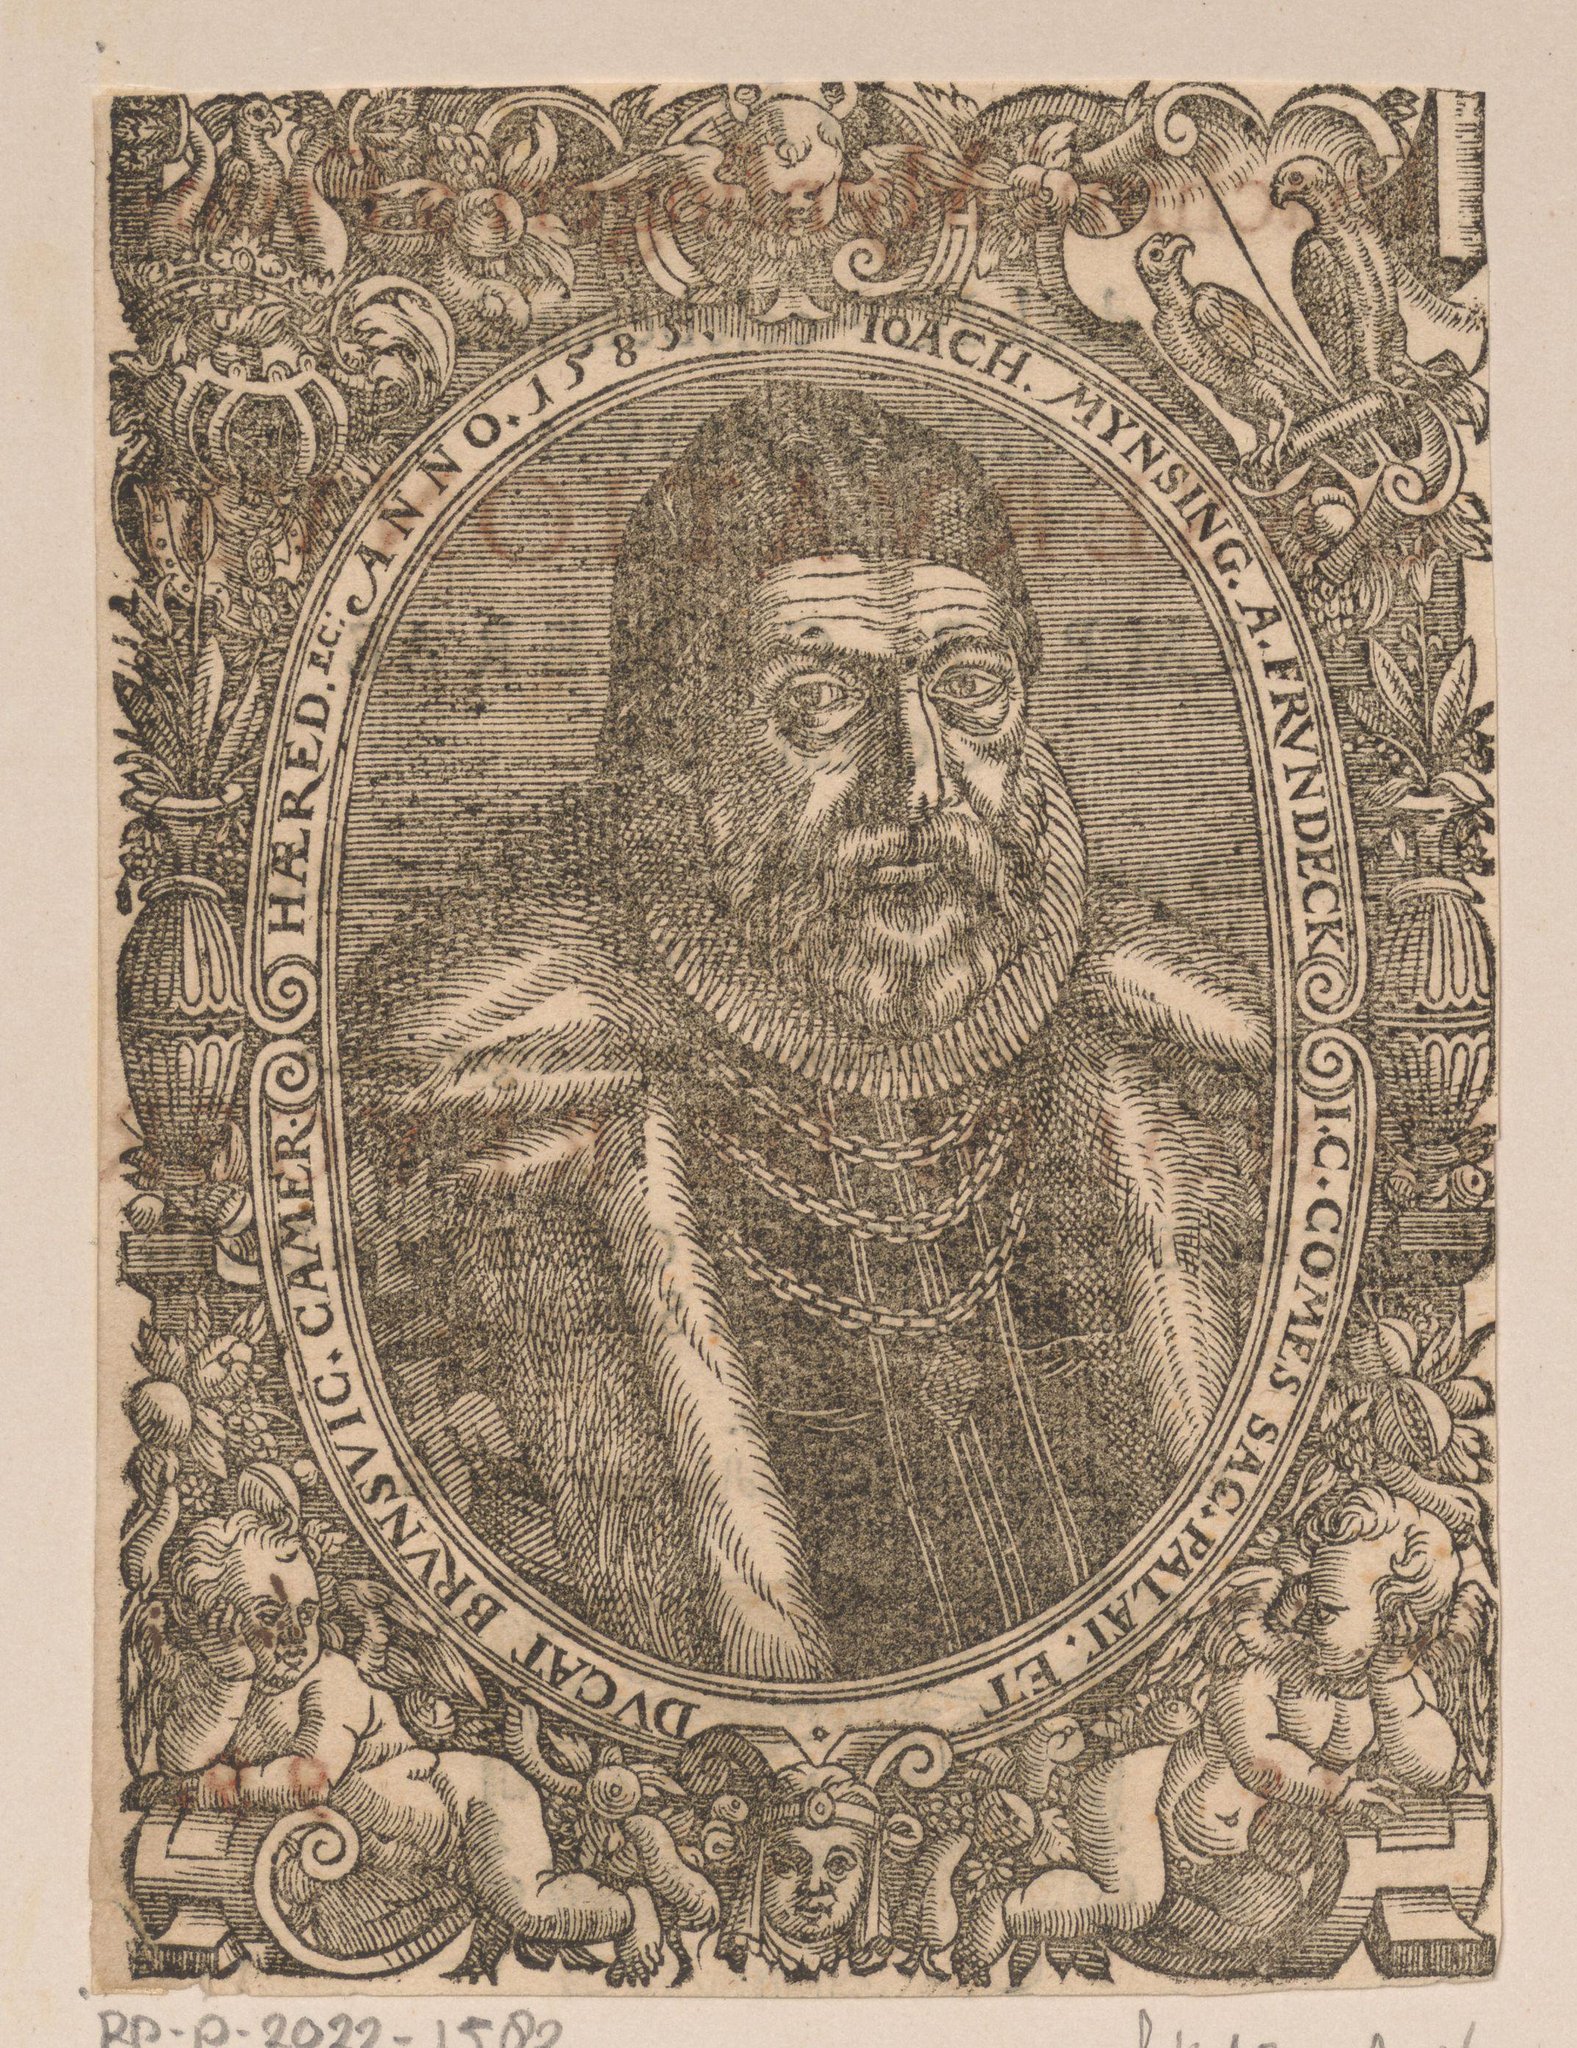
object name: book illustration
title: Portret van Joachim Mynsinger von Frundeck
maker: Anonymous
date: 1599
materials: paper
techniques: letterpress printing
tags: historical persons, magistracy, judges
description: Prent uit: Mynsinger von Frundeck, Joachim en Arnold de Reyger. Singularium Observationum Imper. Camerae Centur. VI. S.l.s.n., 1599.